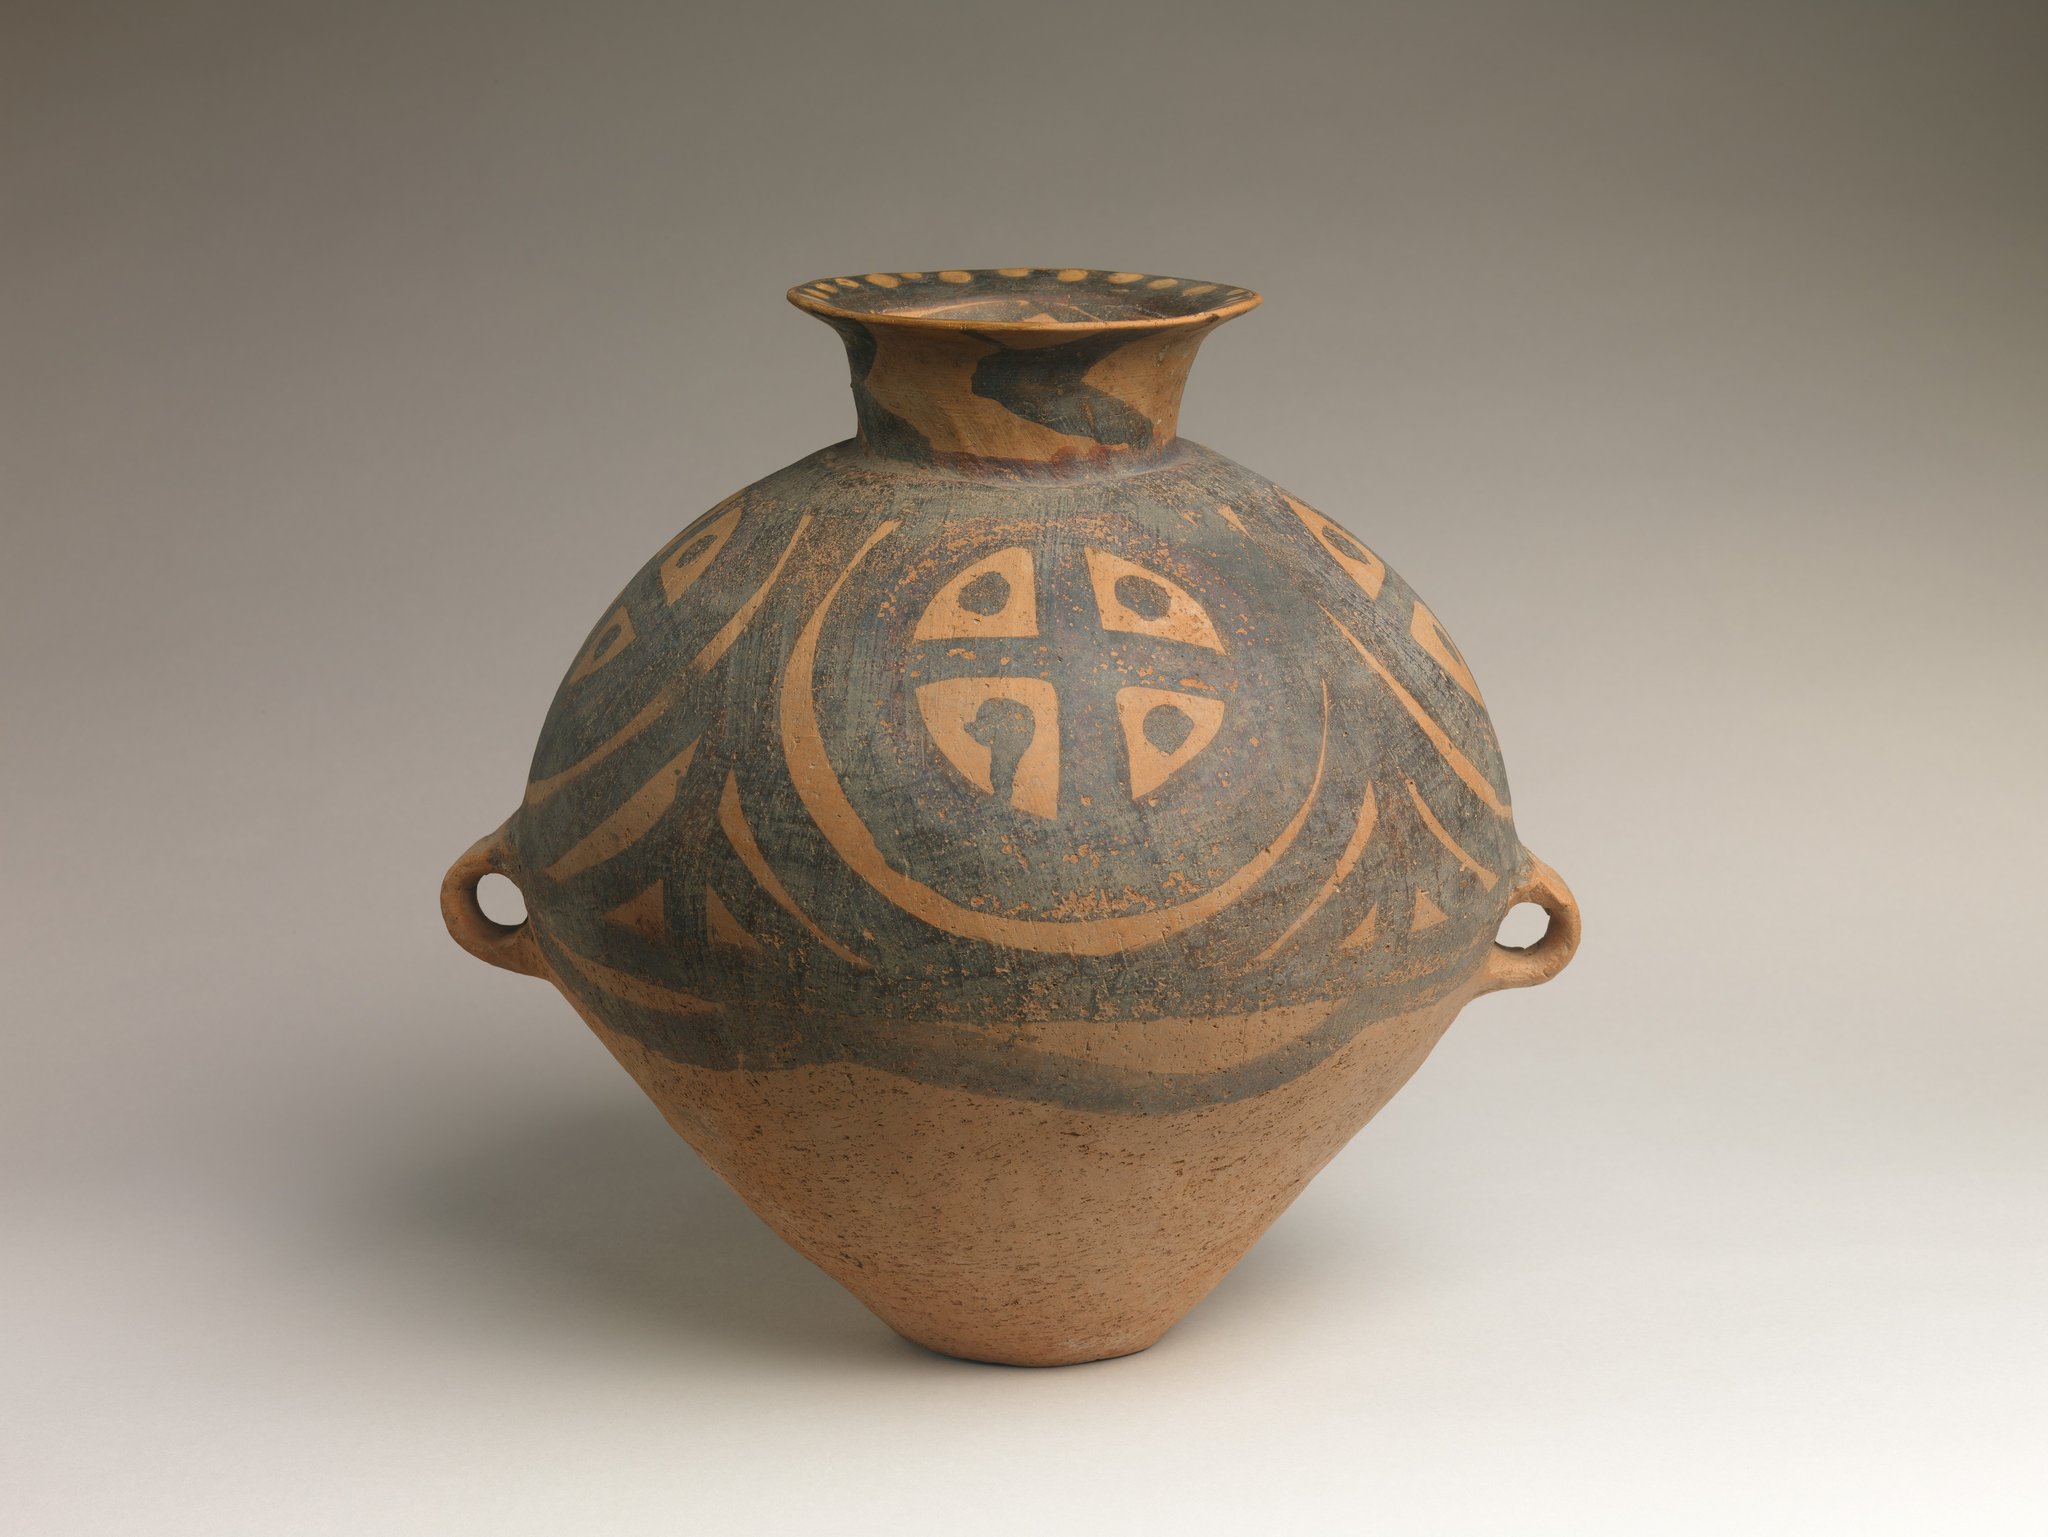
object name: jar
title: Jar (Guan)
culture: chinese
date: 2300-2000 BCE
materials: earthenware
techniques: painting